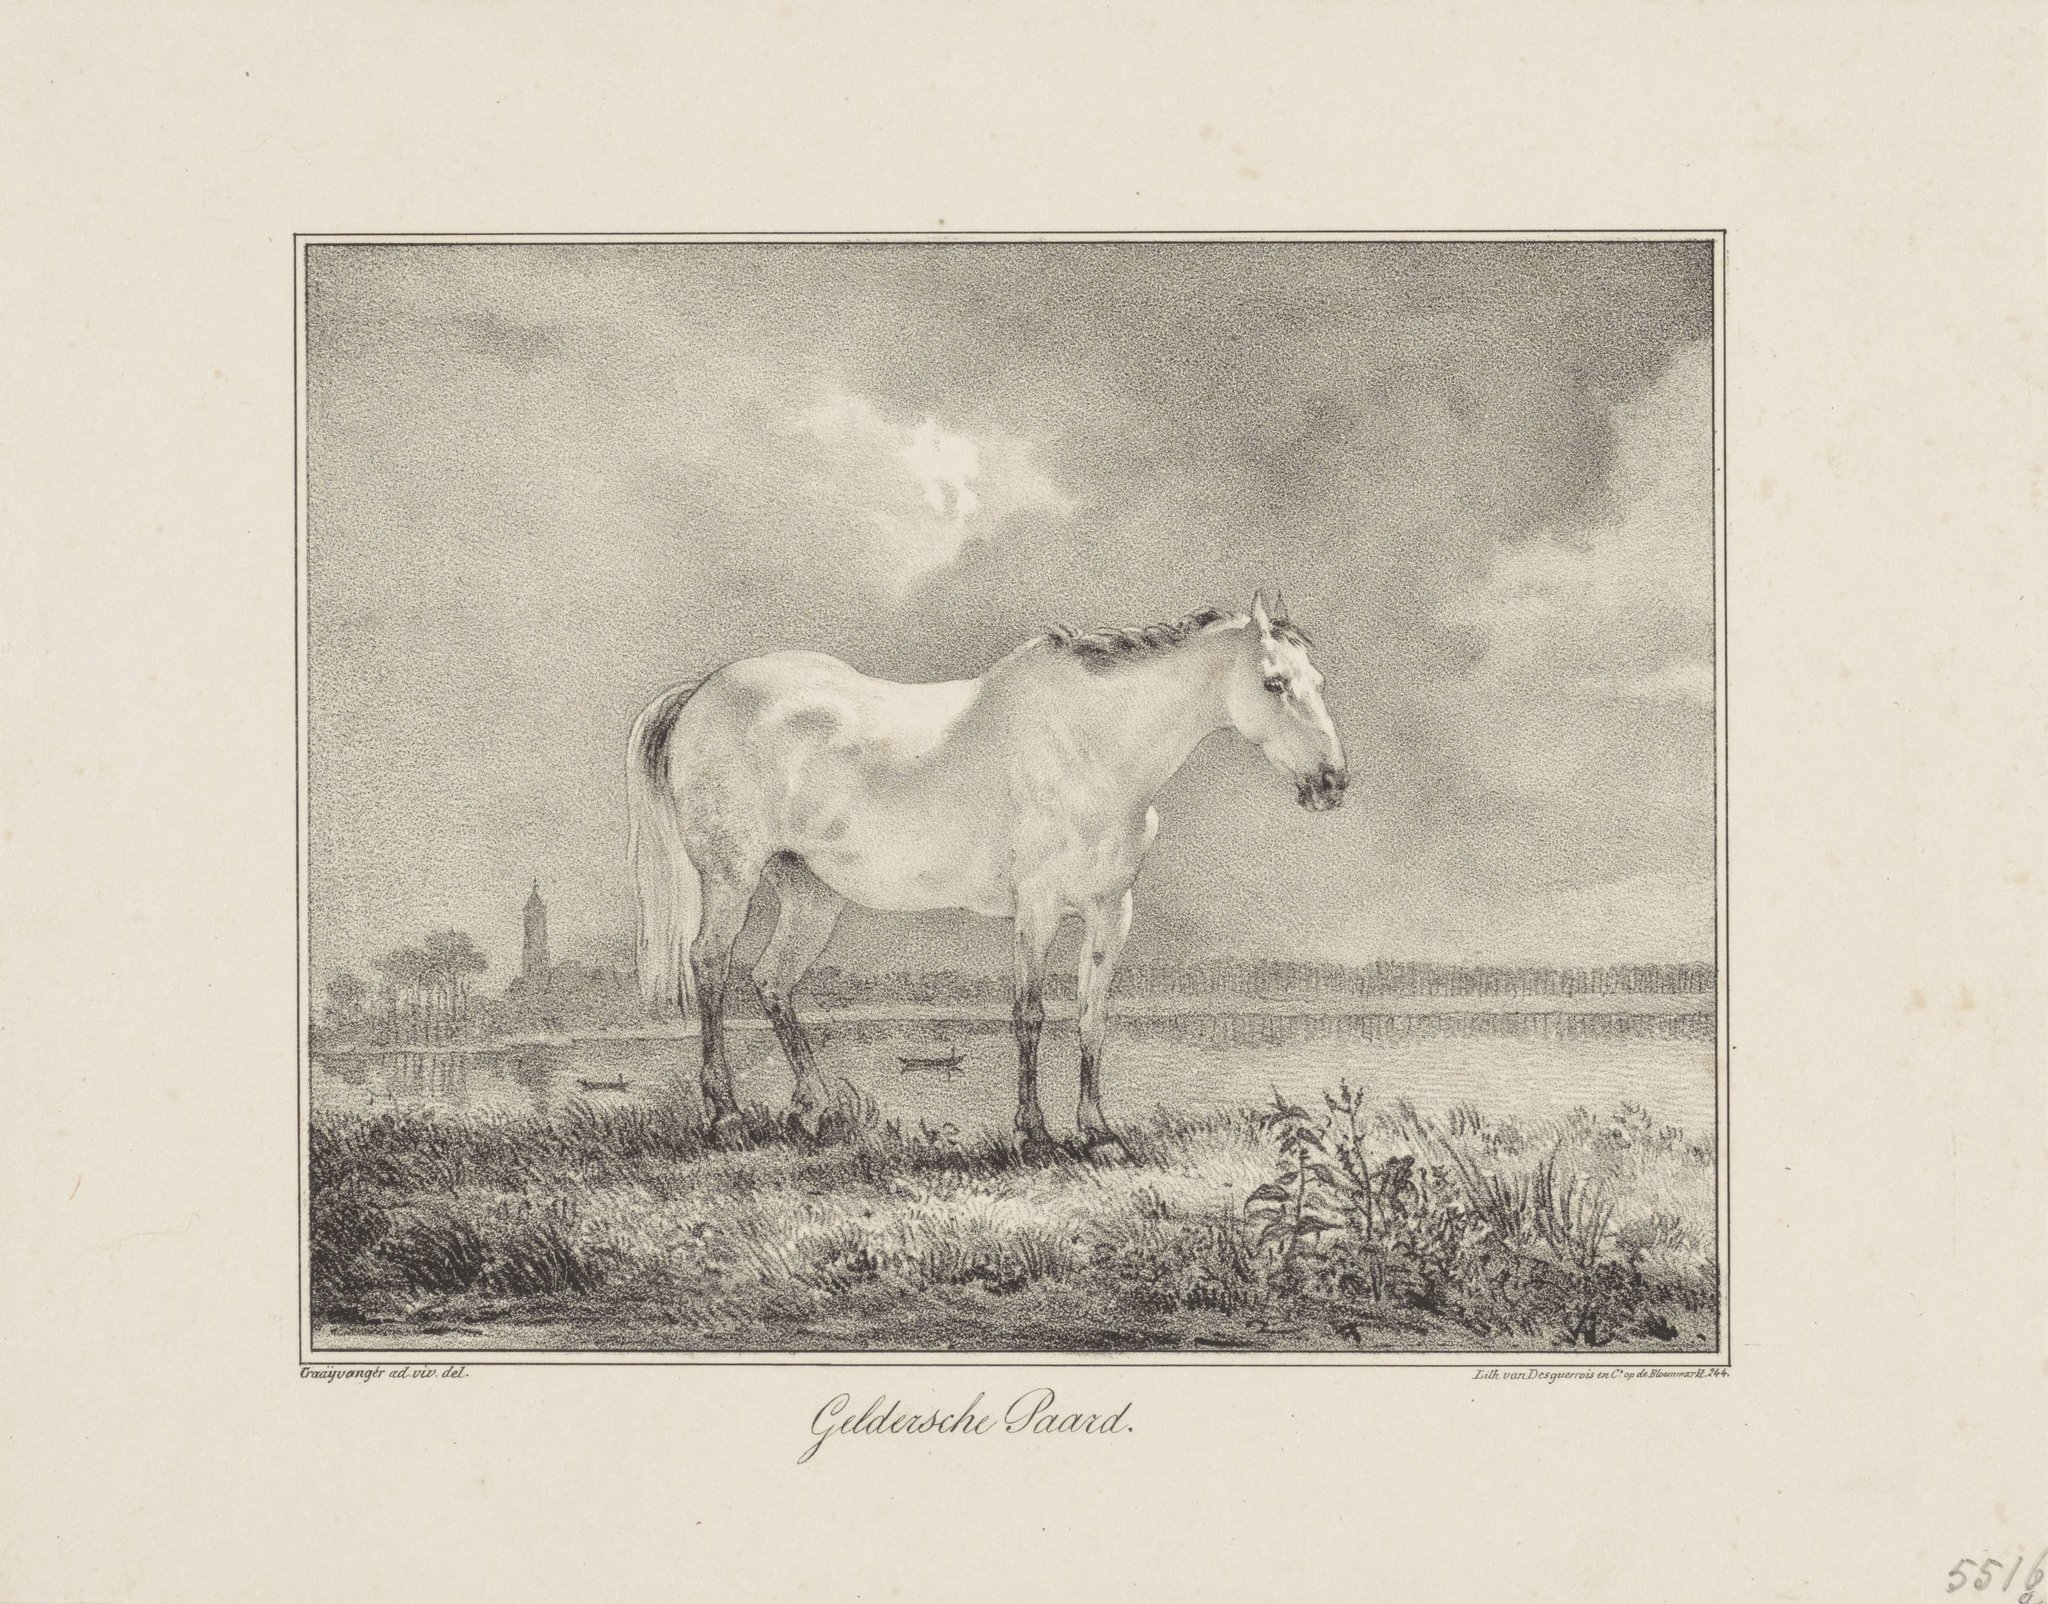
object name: print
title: Geldersche Paard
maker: gijsbertus craeyvanger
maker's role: draughtsman, print maker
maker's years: 1810-1895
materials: paper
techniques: lithograph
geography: netherlands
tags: river bank, horse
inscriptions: collector's mark: Lugt 2228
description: Waarschijnlijk maakte deze prent deel uit van de serie: 'Buitenstudien naar het leven' uitgeven in 1827 door Ambroise Jobard die werd opgevolgd door Desguerrois & Co. Zie Swillens in Jaarboek Oud Utrecht.